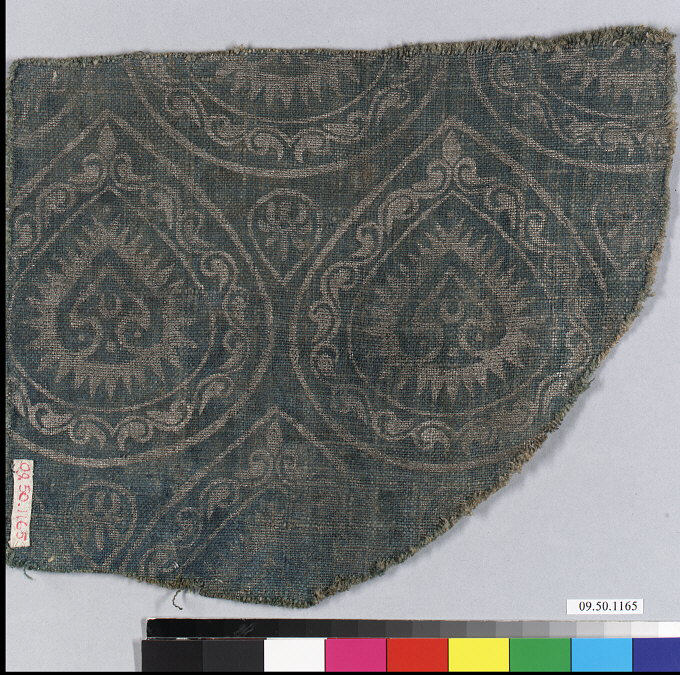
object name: fragment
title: Fragment in 14th century style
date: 1801-1900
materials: linen